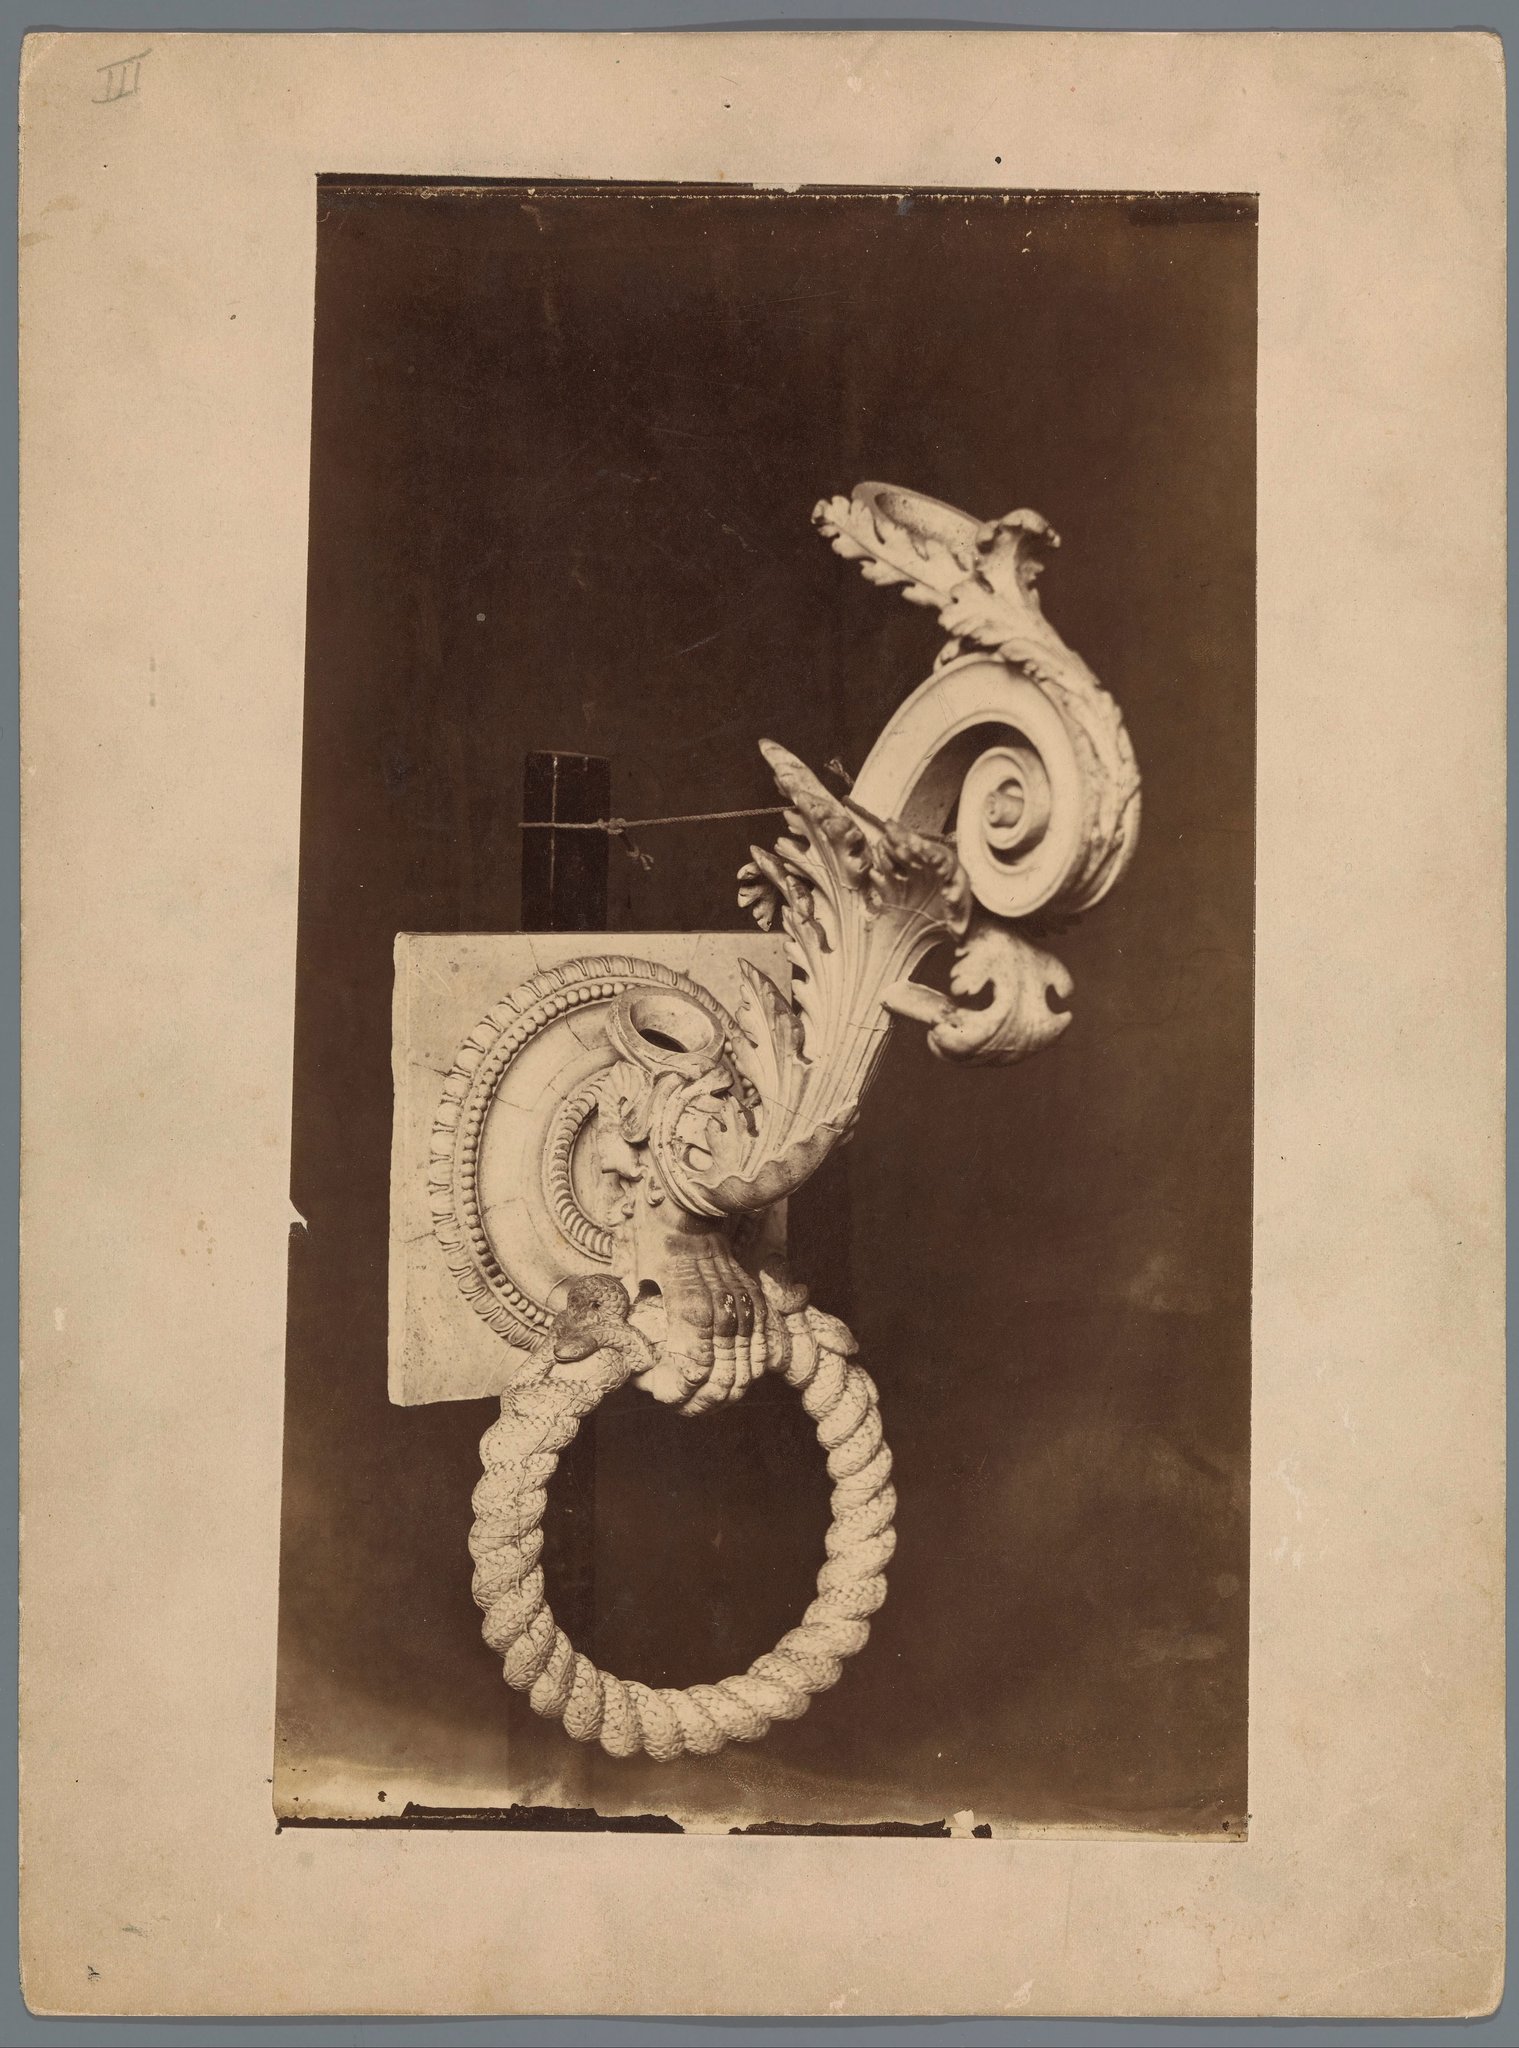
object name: photograph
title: Deurklopper in de vorm van slangen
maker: Anonymous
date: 1875-1900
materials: cardboard, photographic support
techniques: albumen print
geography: europe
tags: snakes, door-knocker, doorbell, ornament ~ arabesque, europe